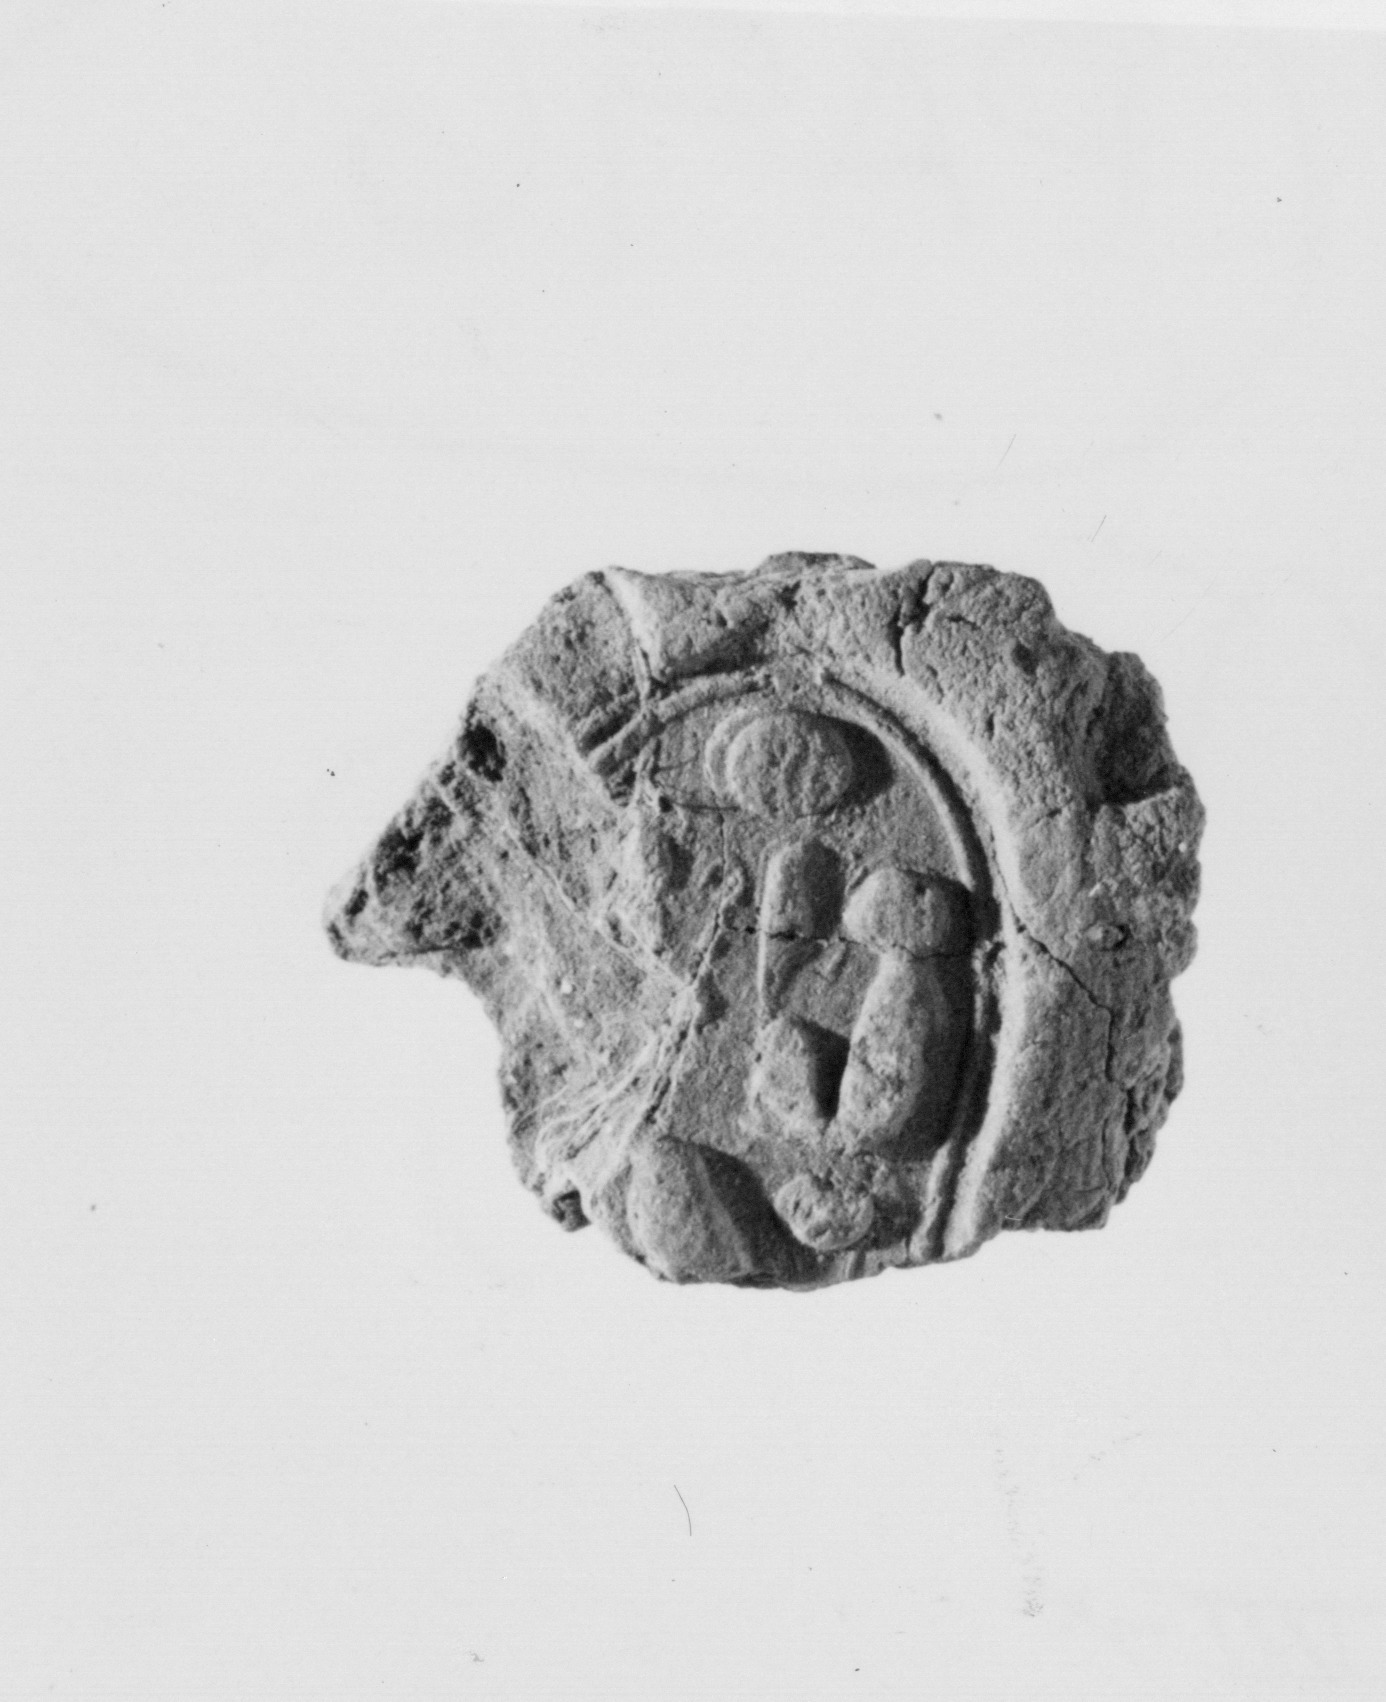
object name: sealing, nebmaatre, amenhotep iii, horus, falcon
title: Document Sealing With the Throne Name of Amenhotep III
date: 1390-1352 BCE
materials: mud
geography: egypt